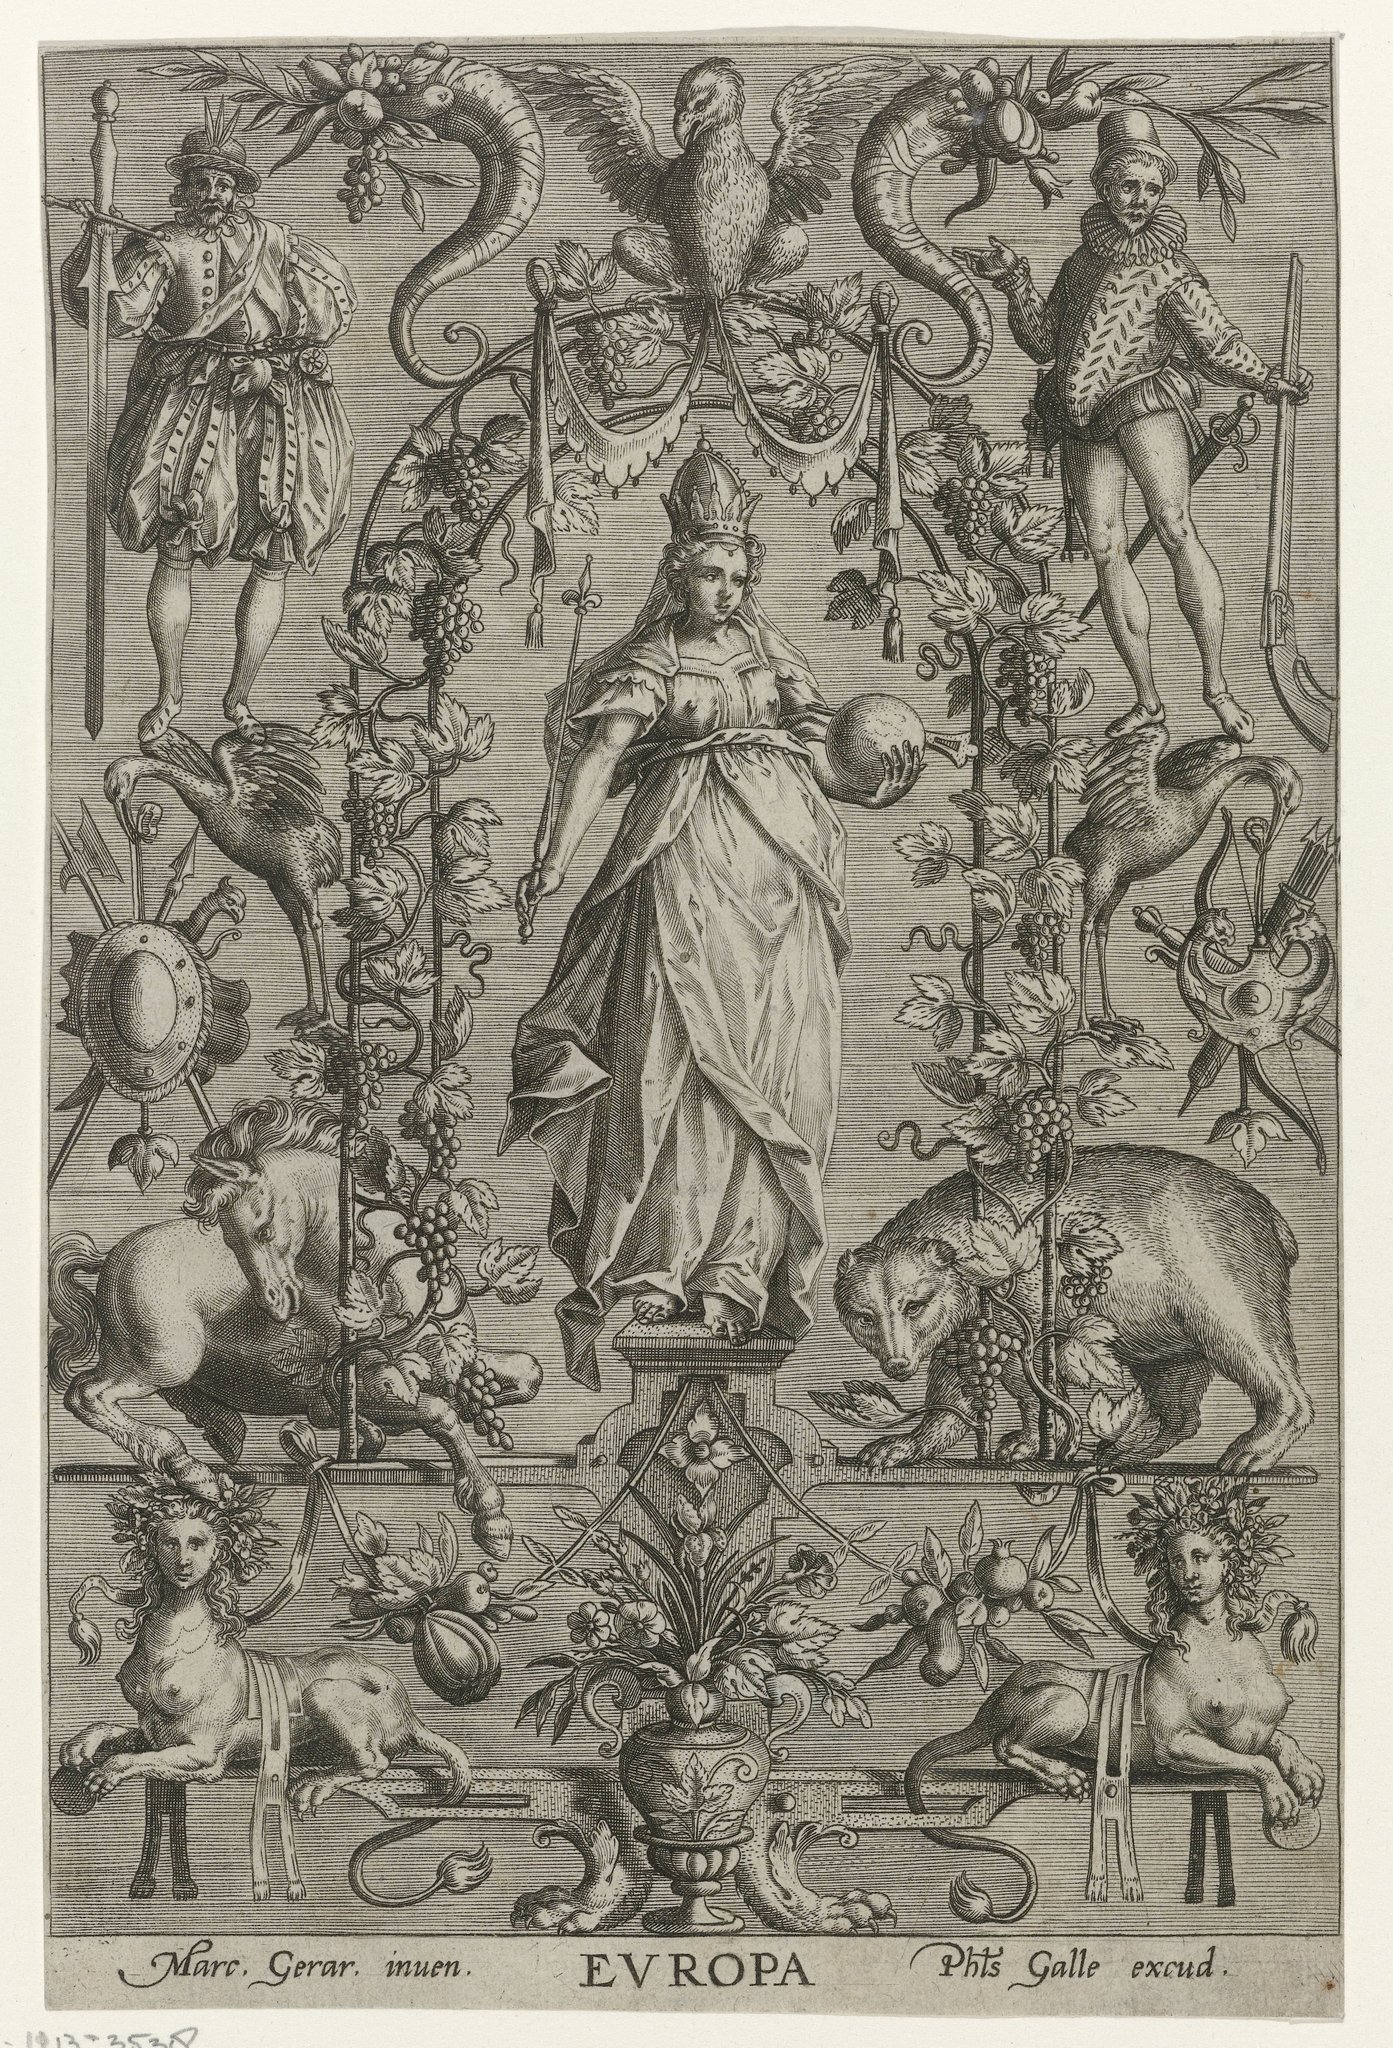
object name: print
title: De vier werelddelen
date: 1547-1622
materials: paper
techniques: engraving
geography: bruges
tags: europe represented allegorically; 'europa' (ripa), ornament ~ arabesque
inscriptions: collector's mark: Lugt 2228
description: De personificatie van Europa, staande op een sokkel onder een ornamentele triomfboog waaraan wijnranken groeien. Ze heeft een scepter en een wereldbol in haar handen. Links en rechts van haar een beer en en paard. Boven haar een arend, geflankeerd door twee cornucopiae en twee gewapende mannen. Onderaan de prent twee sfinxen. De prent is deel van een reeks over de vier werelddelen.